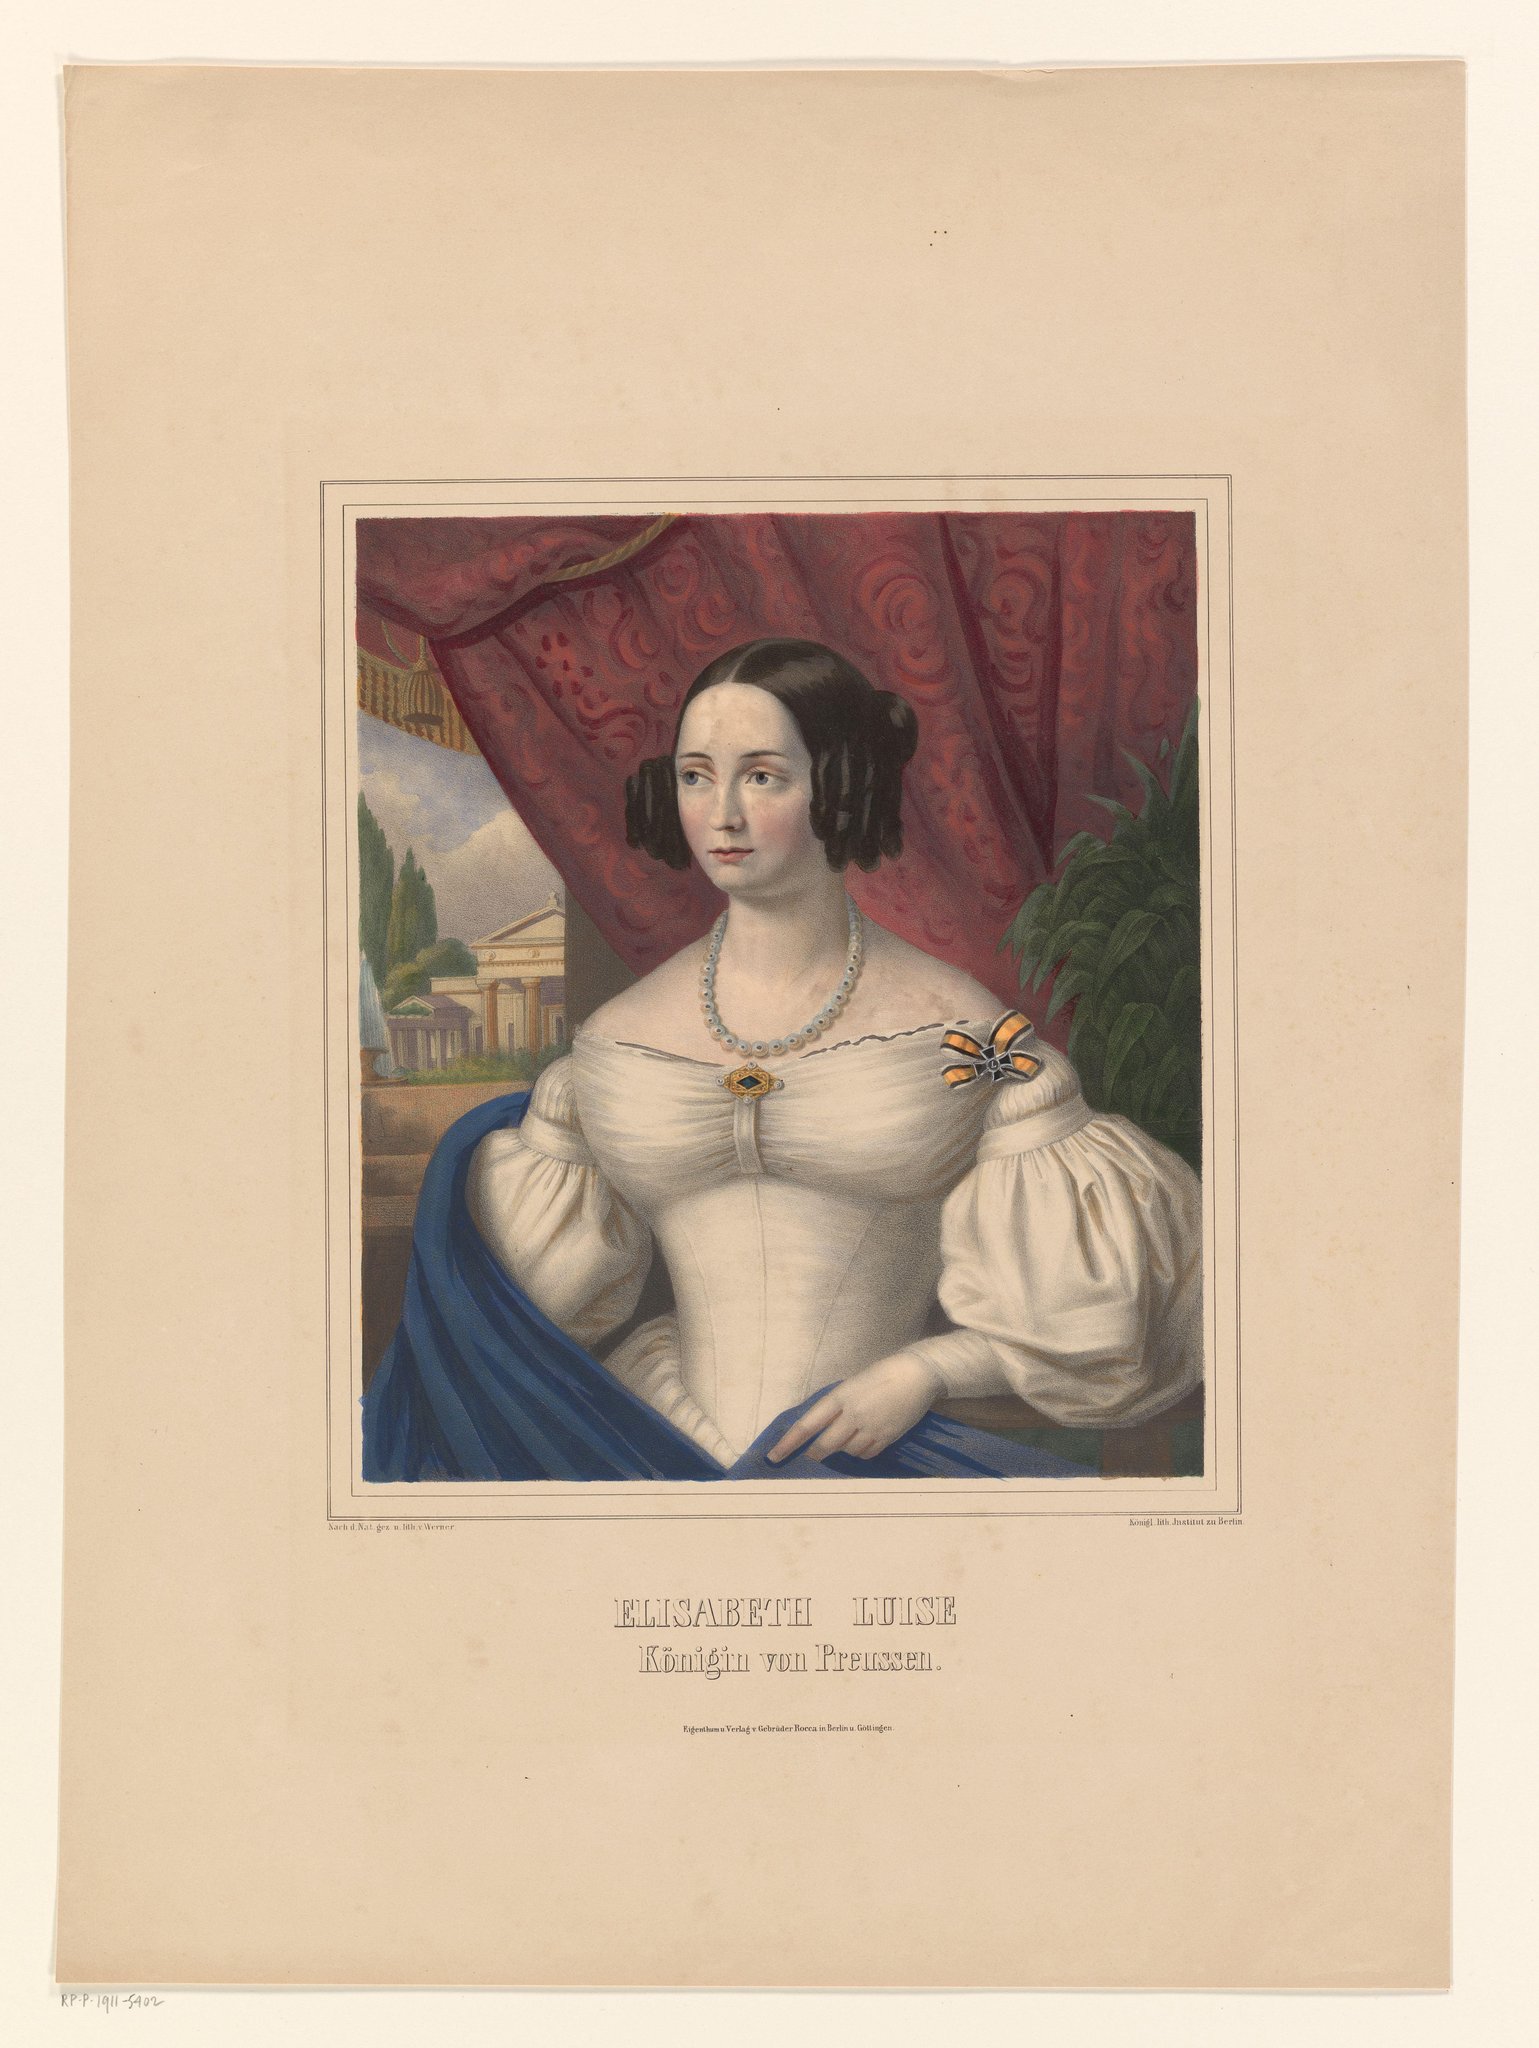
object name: print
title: Portret van Elisabeth Ludovika van Beieren, koningin van Pruisen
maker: wilhelm werner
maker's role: print maker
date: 1823-1845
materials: paper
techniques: hand coloring, lithograph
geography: berlin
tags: curtains, adult woman, historical persons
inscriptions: check stamp: Lugt 5514, collector's mark: Lugt 2228